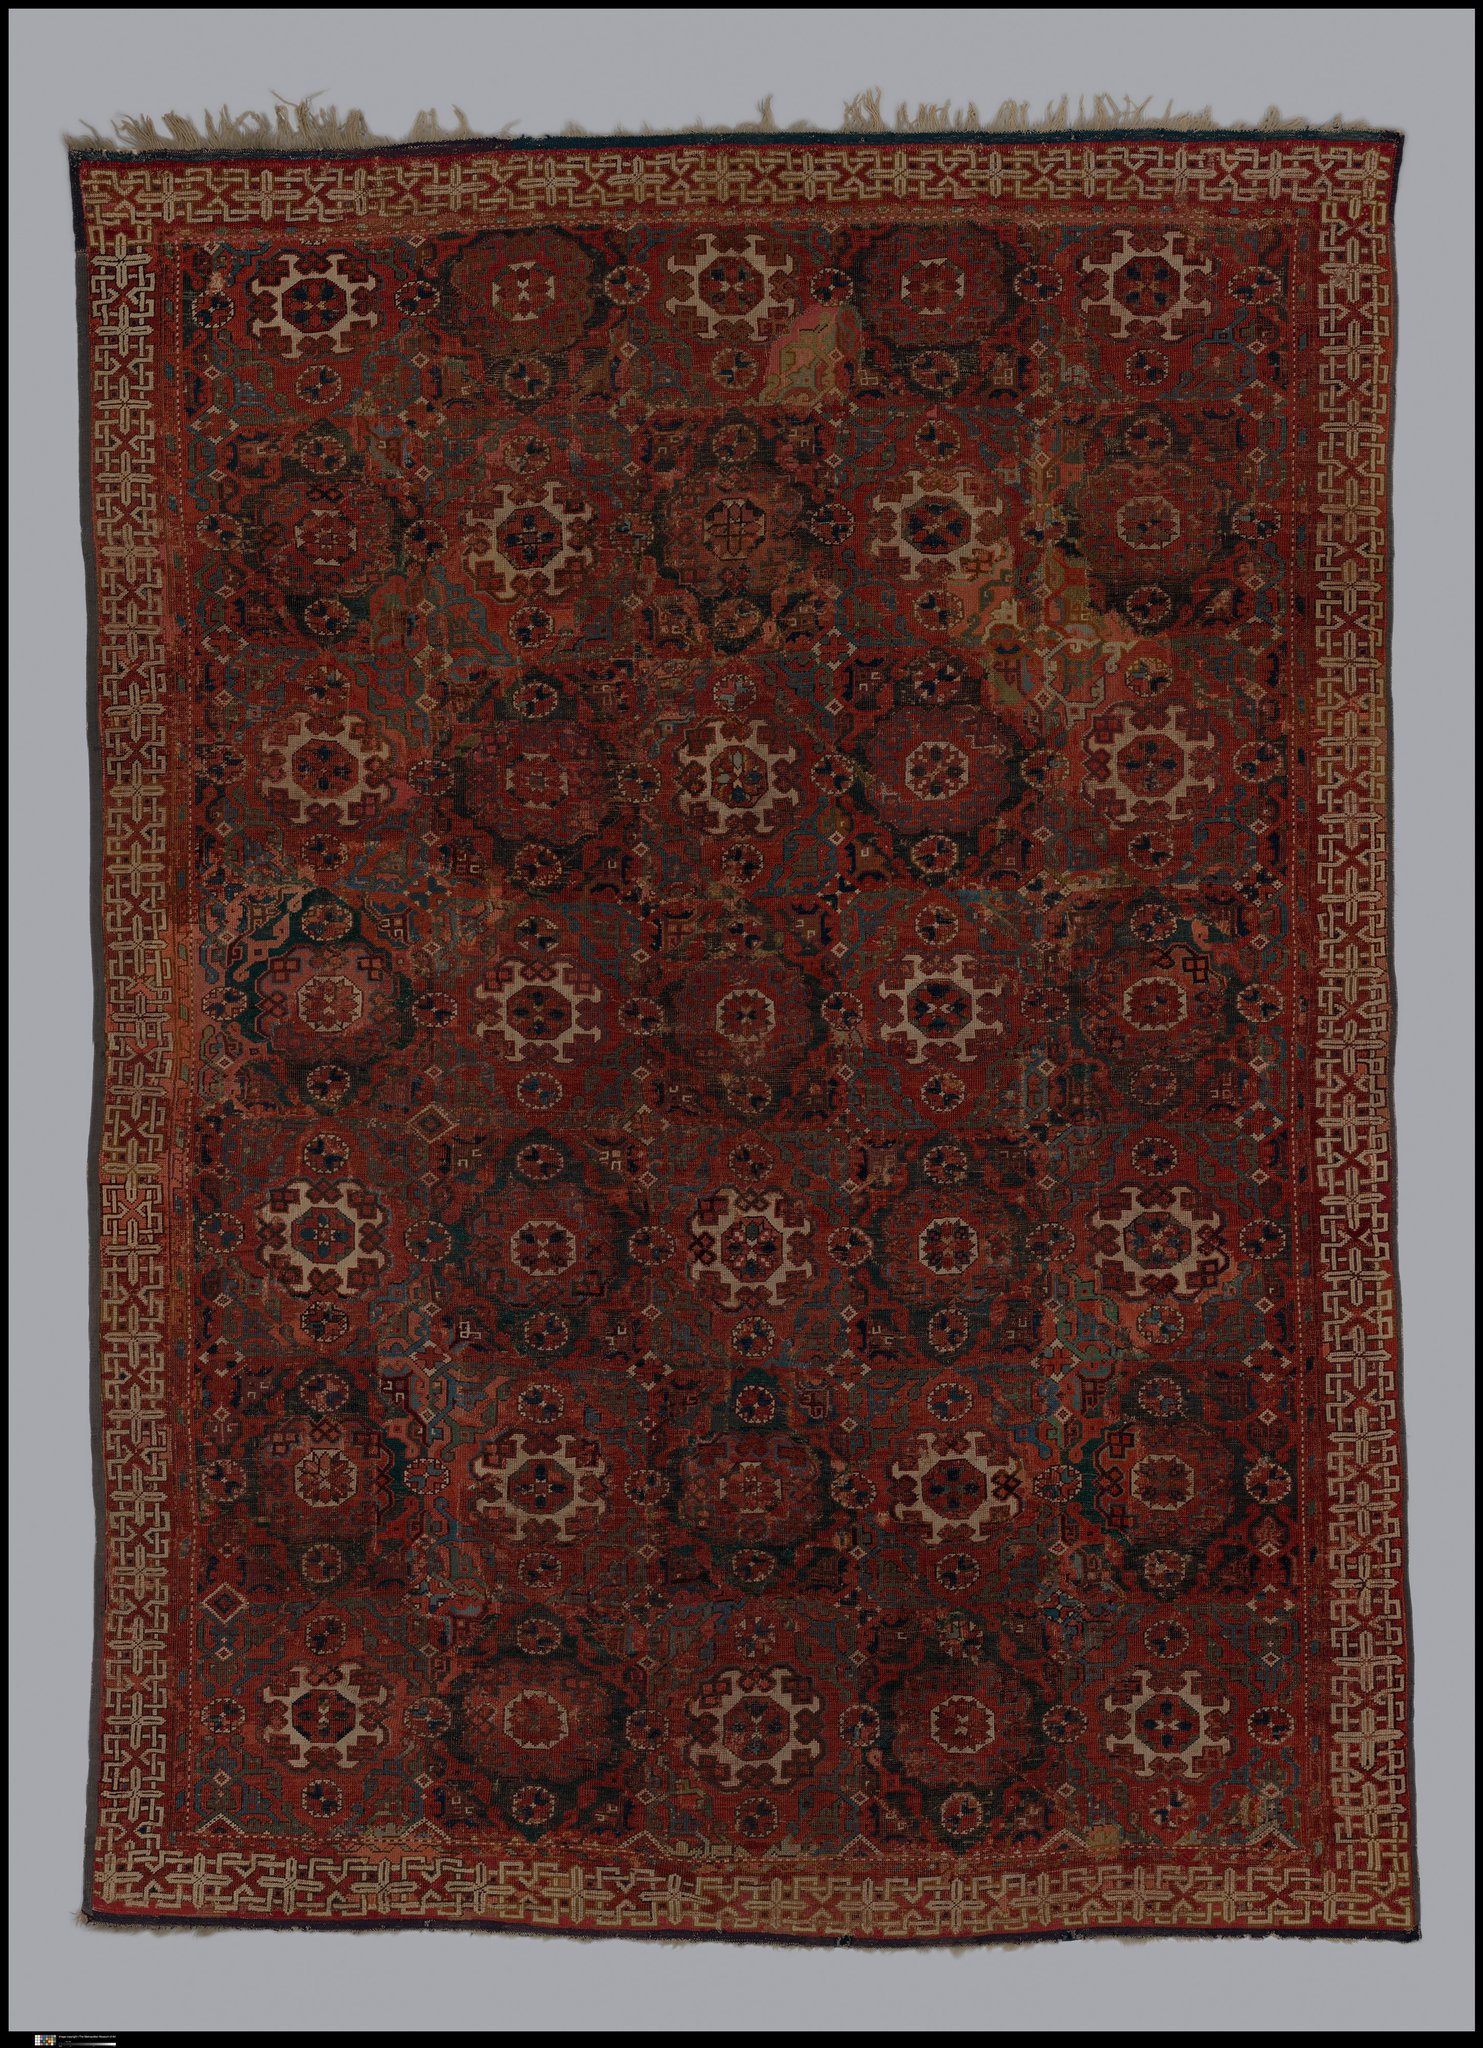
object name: carpet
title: 'Holbein' Carpet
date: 1401-1600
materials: wool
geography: turkey